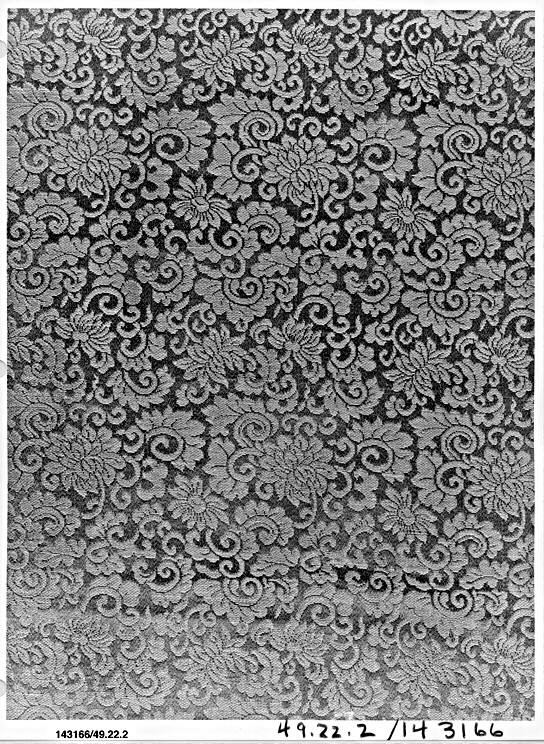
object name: piece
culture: chinese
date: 1901-2000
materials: metal thread, silk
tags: flowers